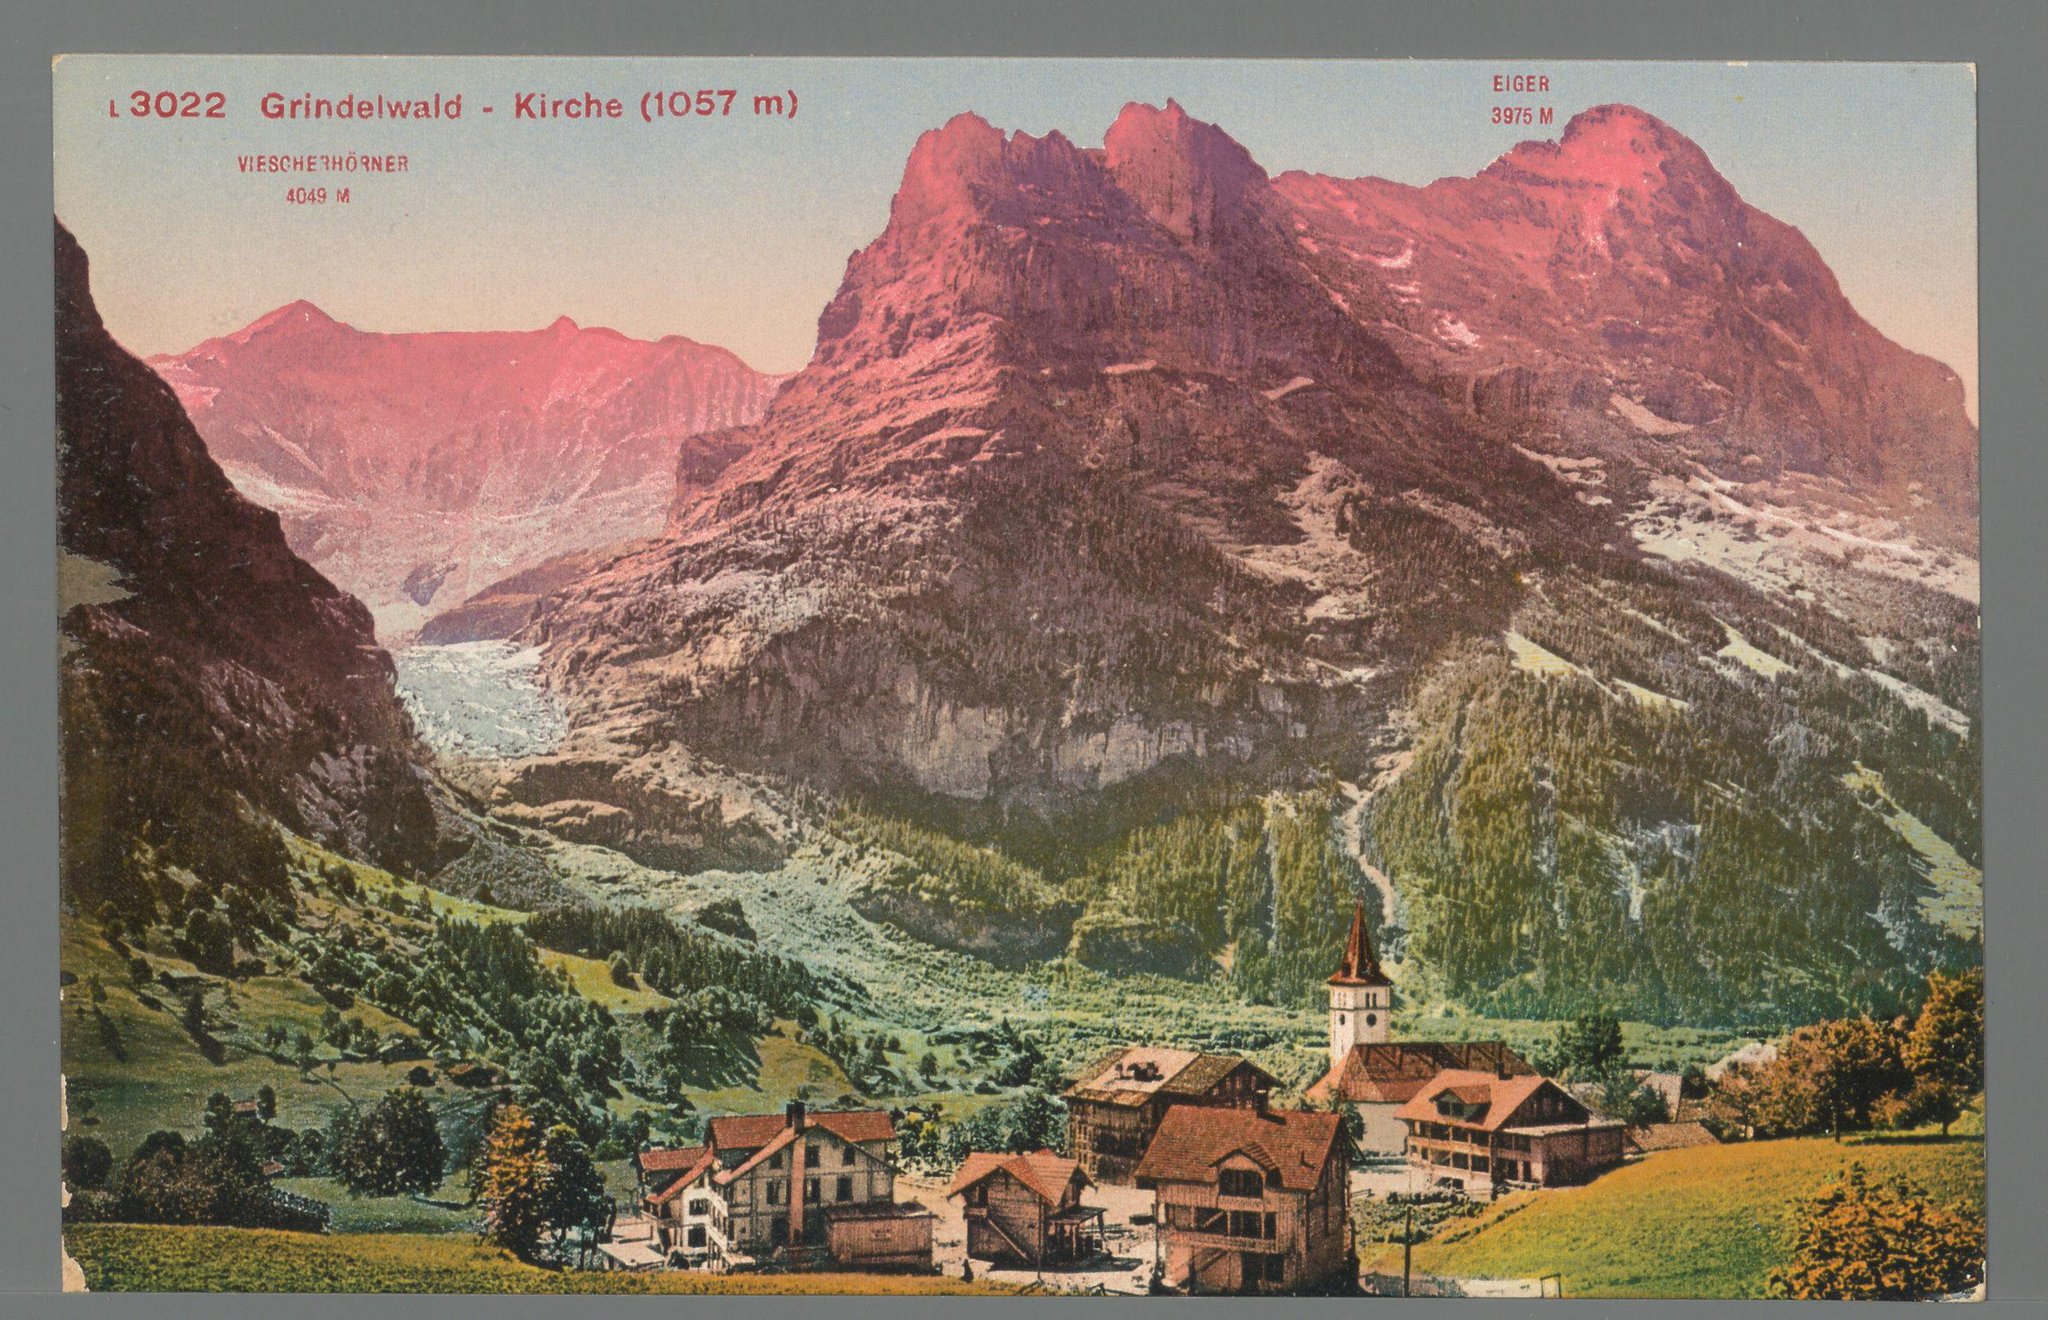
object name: photomechanical print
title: Grindelwald. Kirche (1057 m)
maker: Anonymous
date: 1905-1930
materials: cardboard, photographic process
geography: grindelwald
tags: prospect of village, silhouette of village, church (exterior), mountain-range, snow peaks